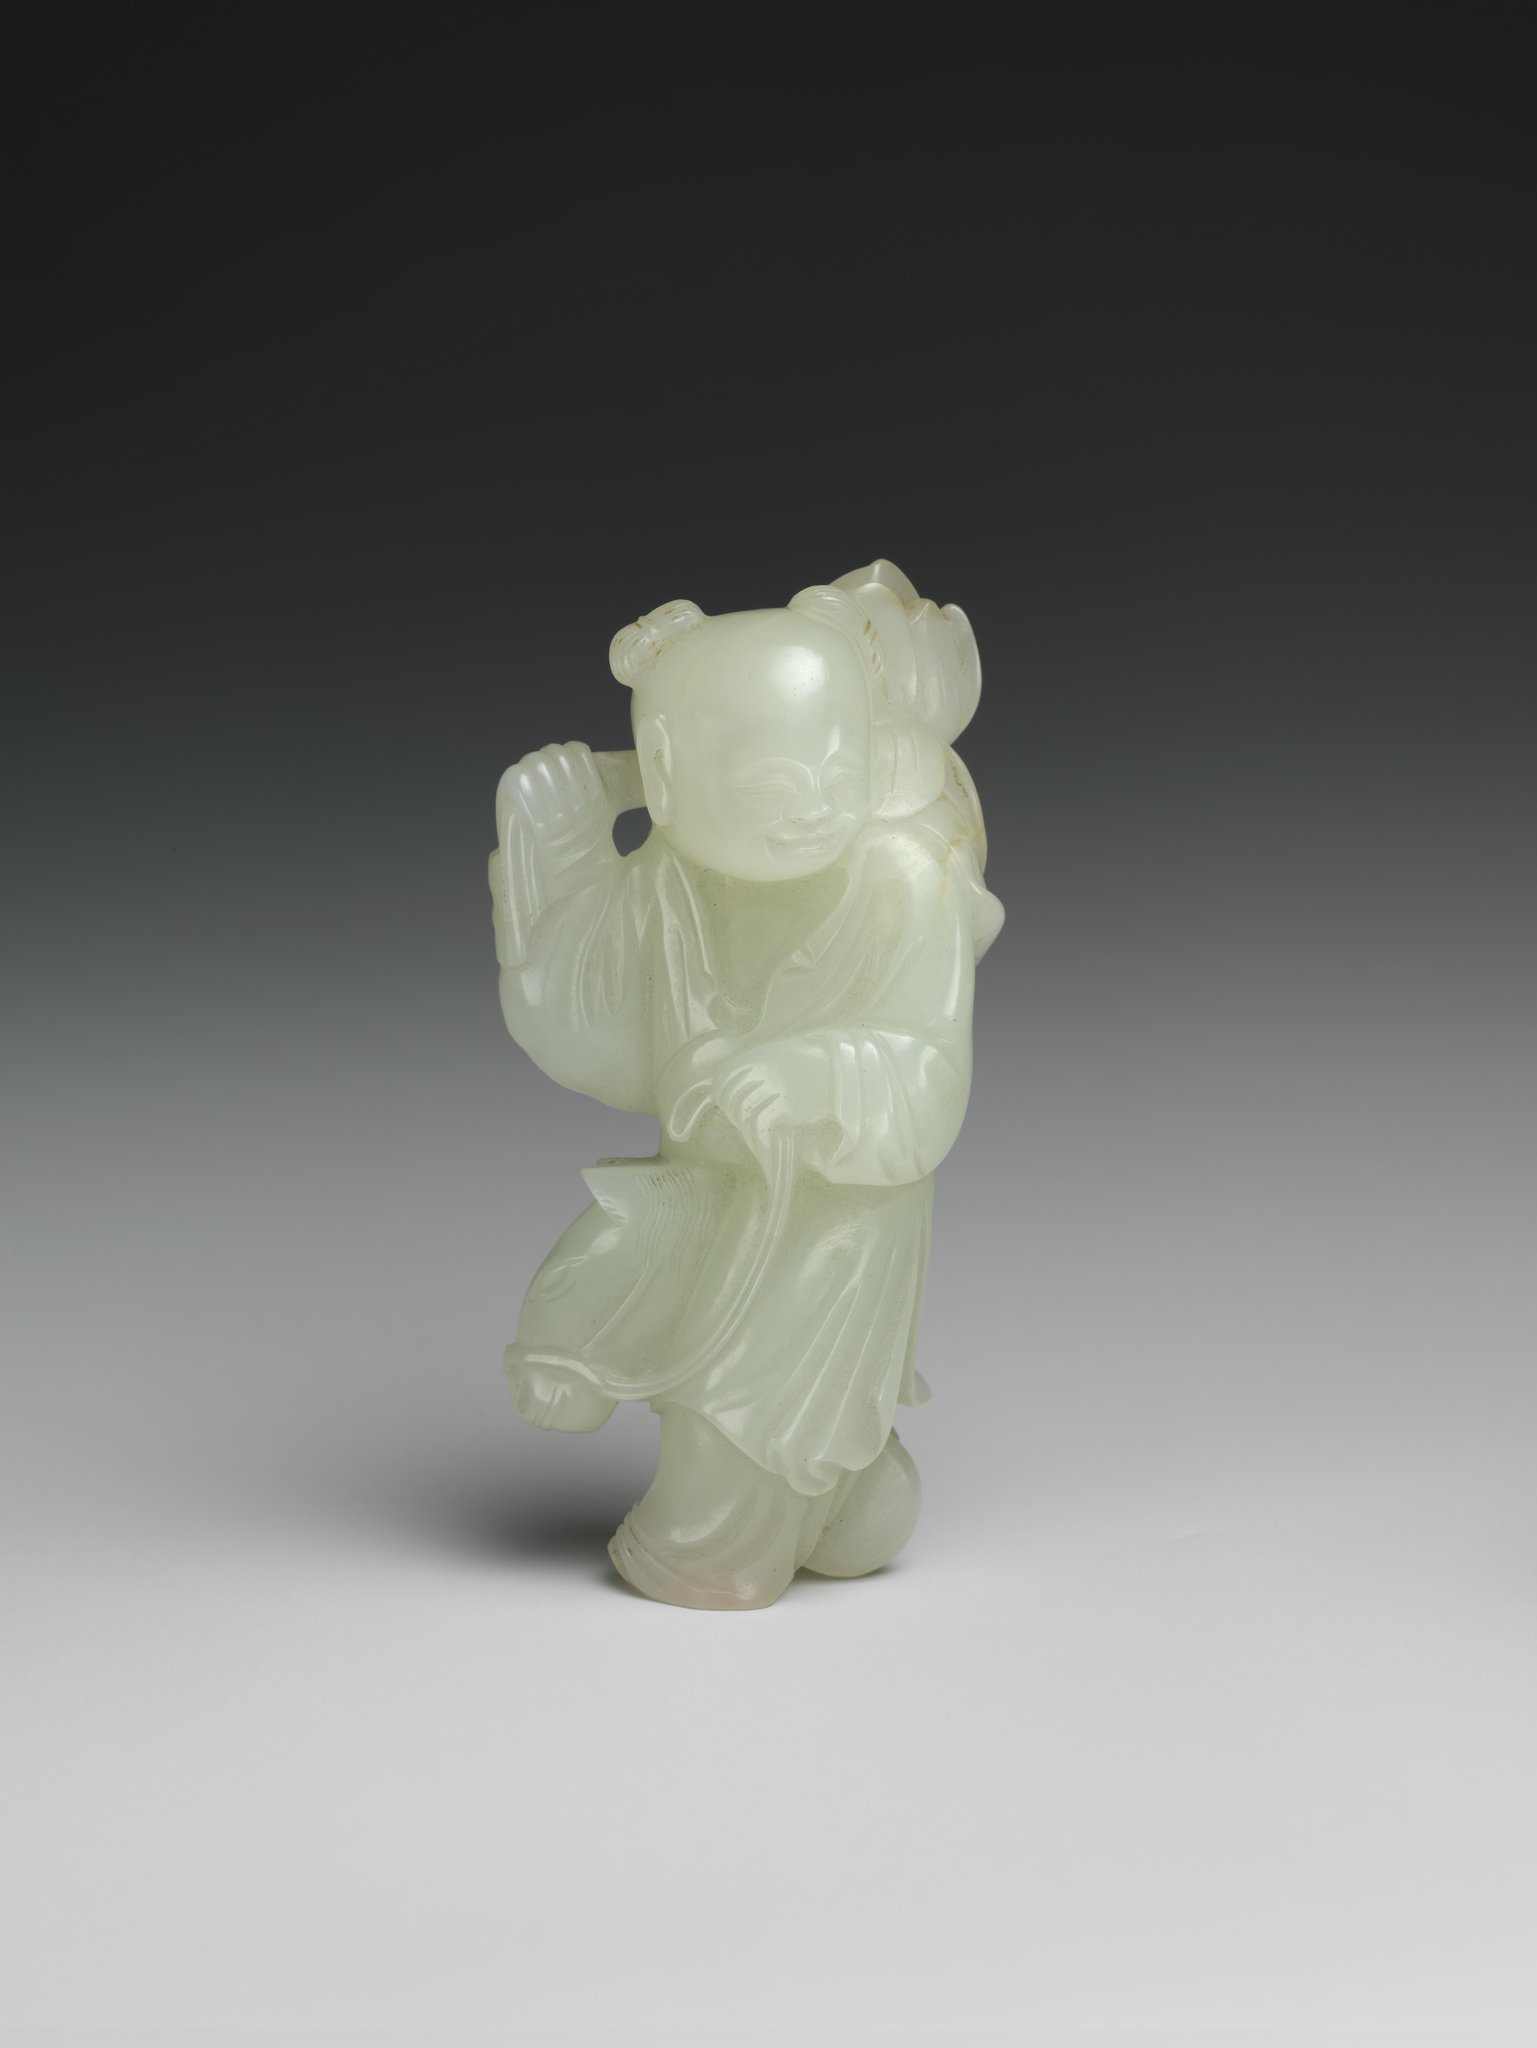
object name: figure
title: Boy riding a hobbyhorse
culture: chinese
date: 1701-1800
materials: jade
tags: boys,lotuses